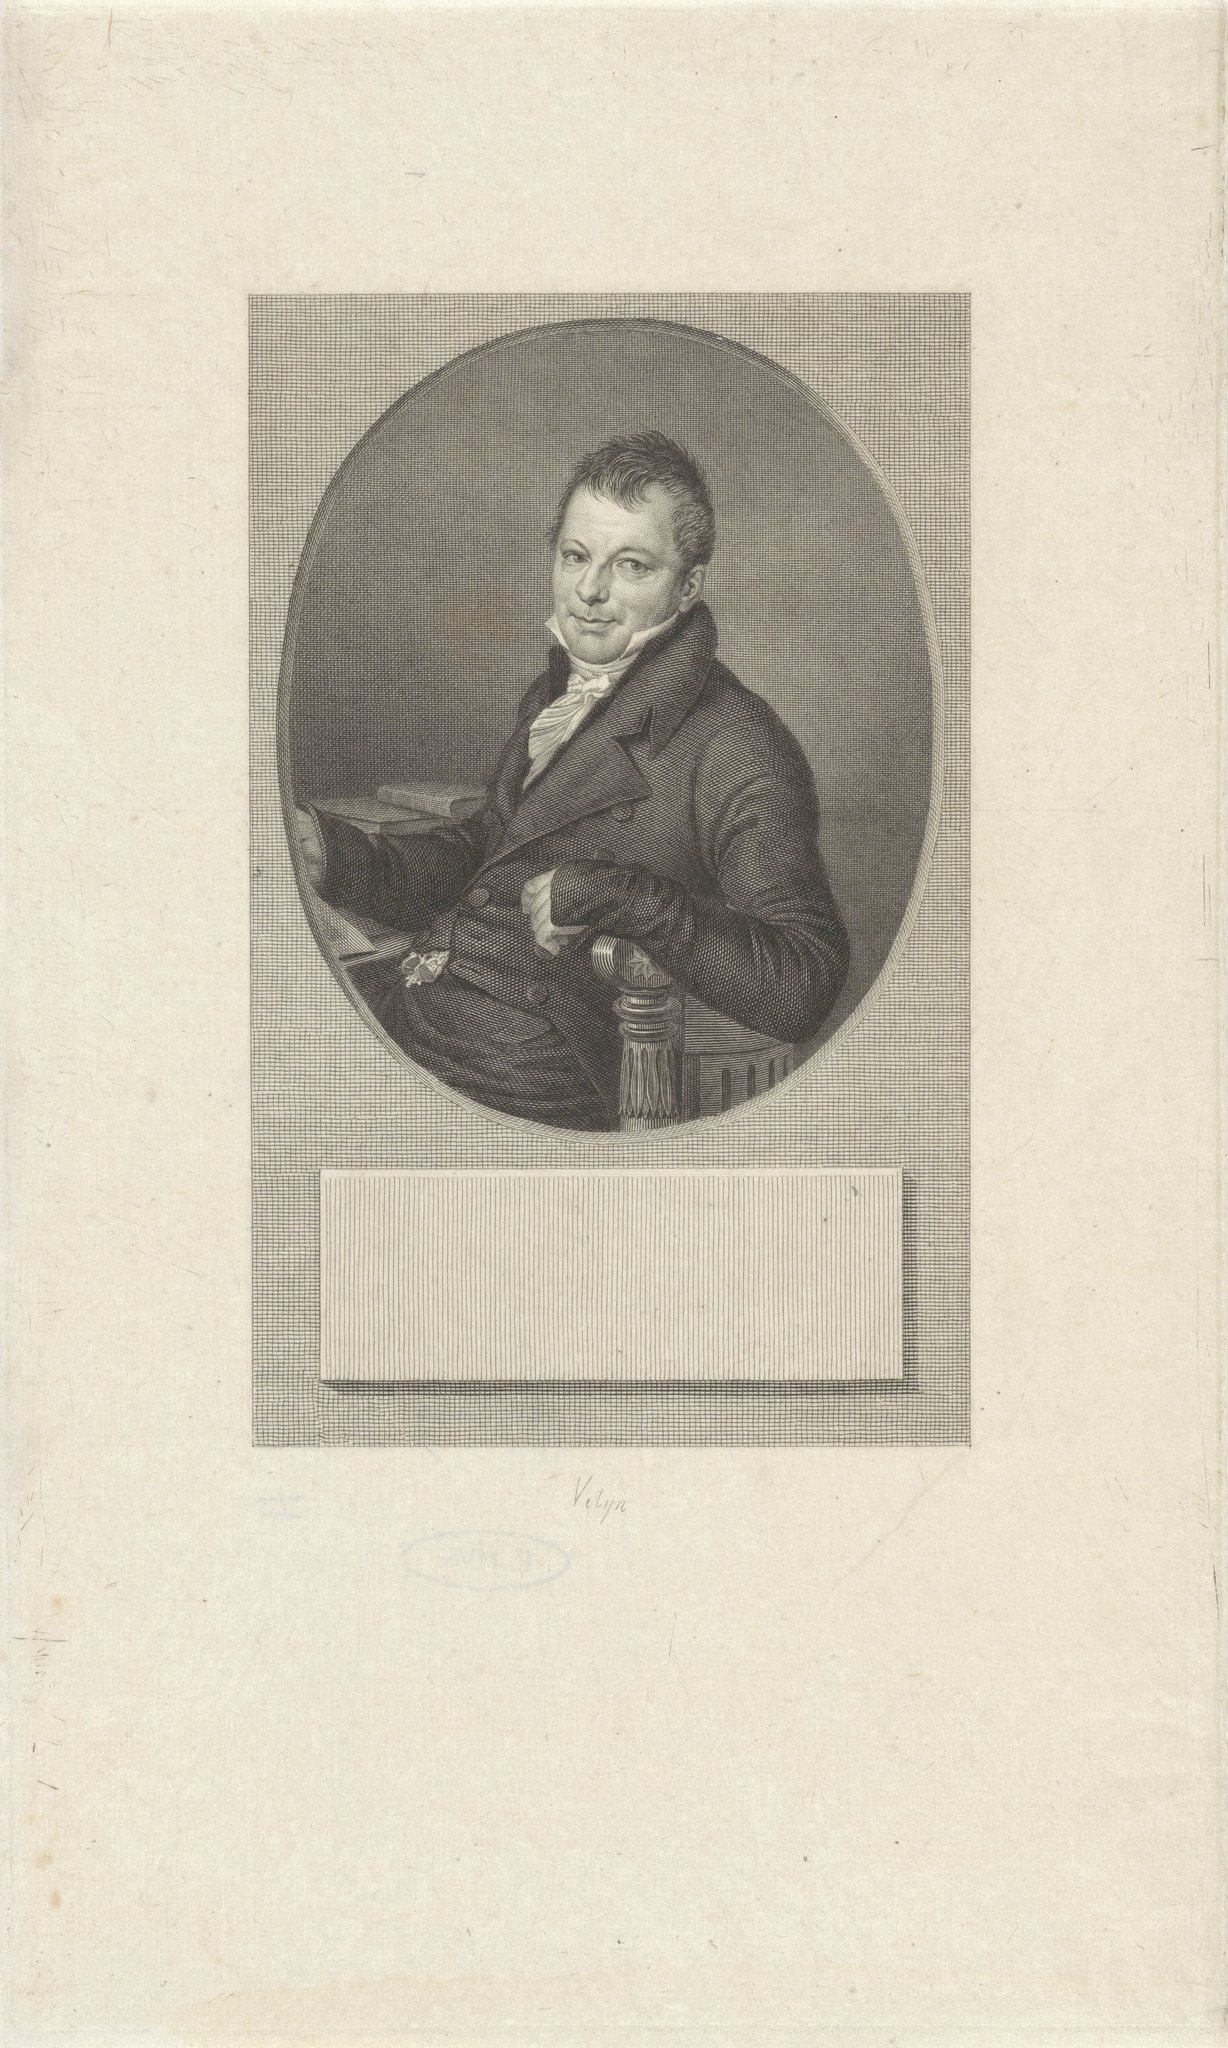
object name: print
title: Portret van Johannes Hermannus Molkenboer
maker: philippus velijn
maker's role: print maker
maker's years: 1787-1836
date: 1797-1836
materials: paper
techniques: engraving, etching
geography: netherlands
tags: johannes hermannus molkenboer, historical persons, art collector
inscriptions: collector's mark: Lugt 2228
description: Portret van Johannes Hermanus Molkenboer, kunstverzamelaar te Amsterdam, zittend aan een tafel.